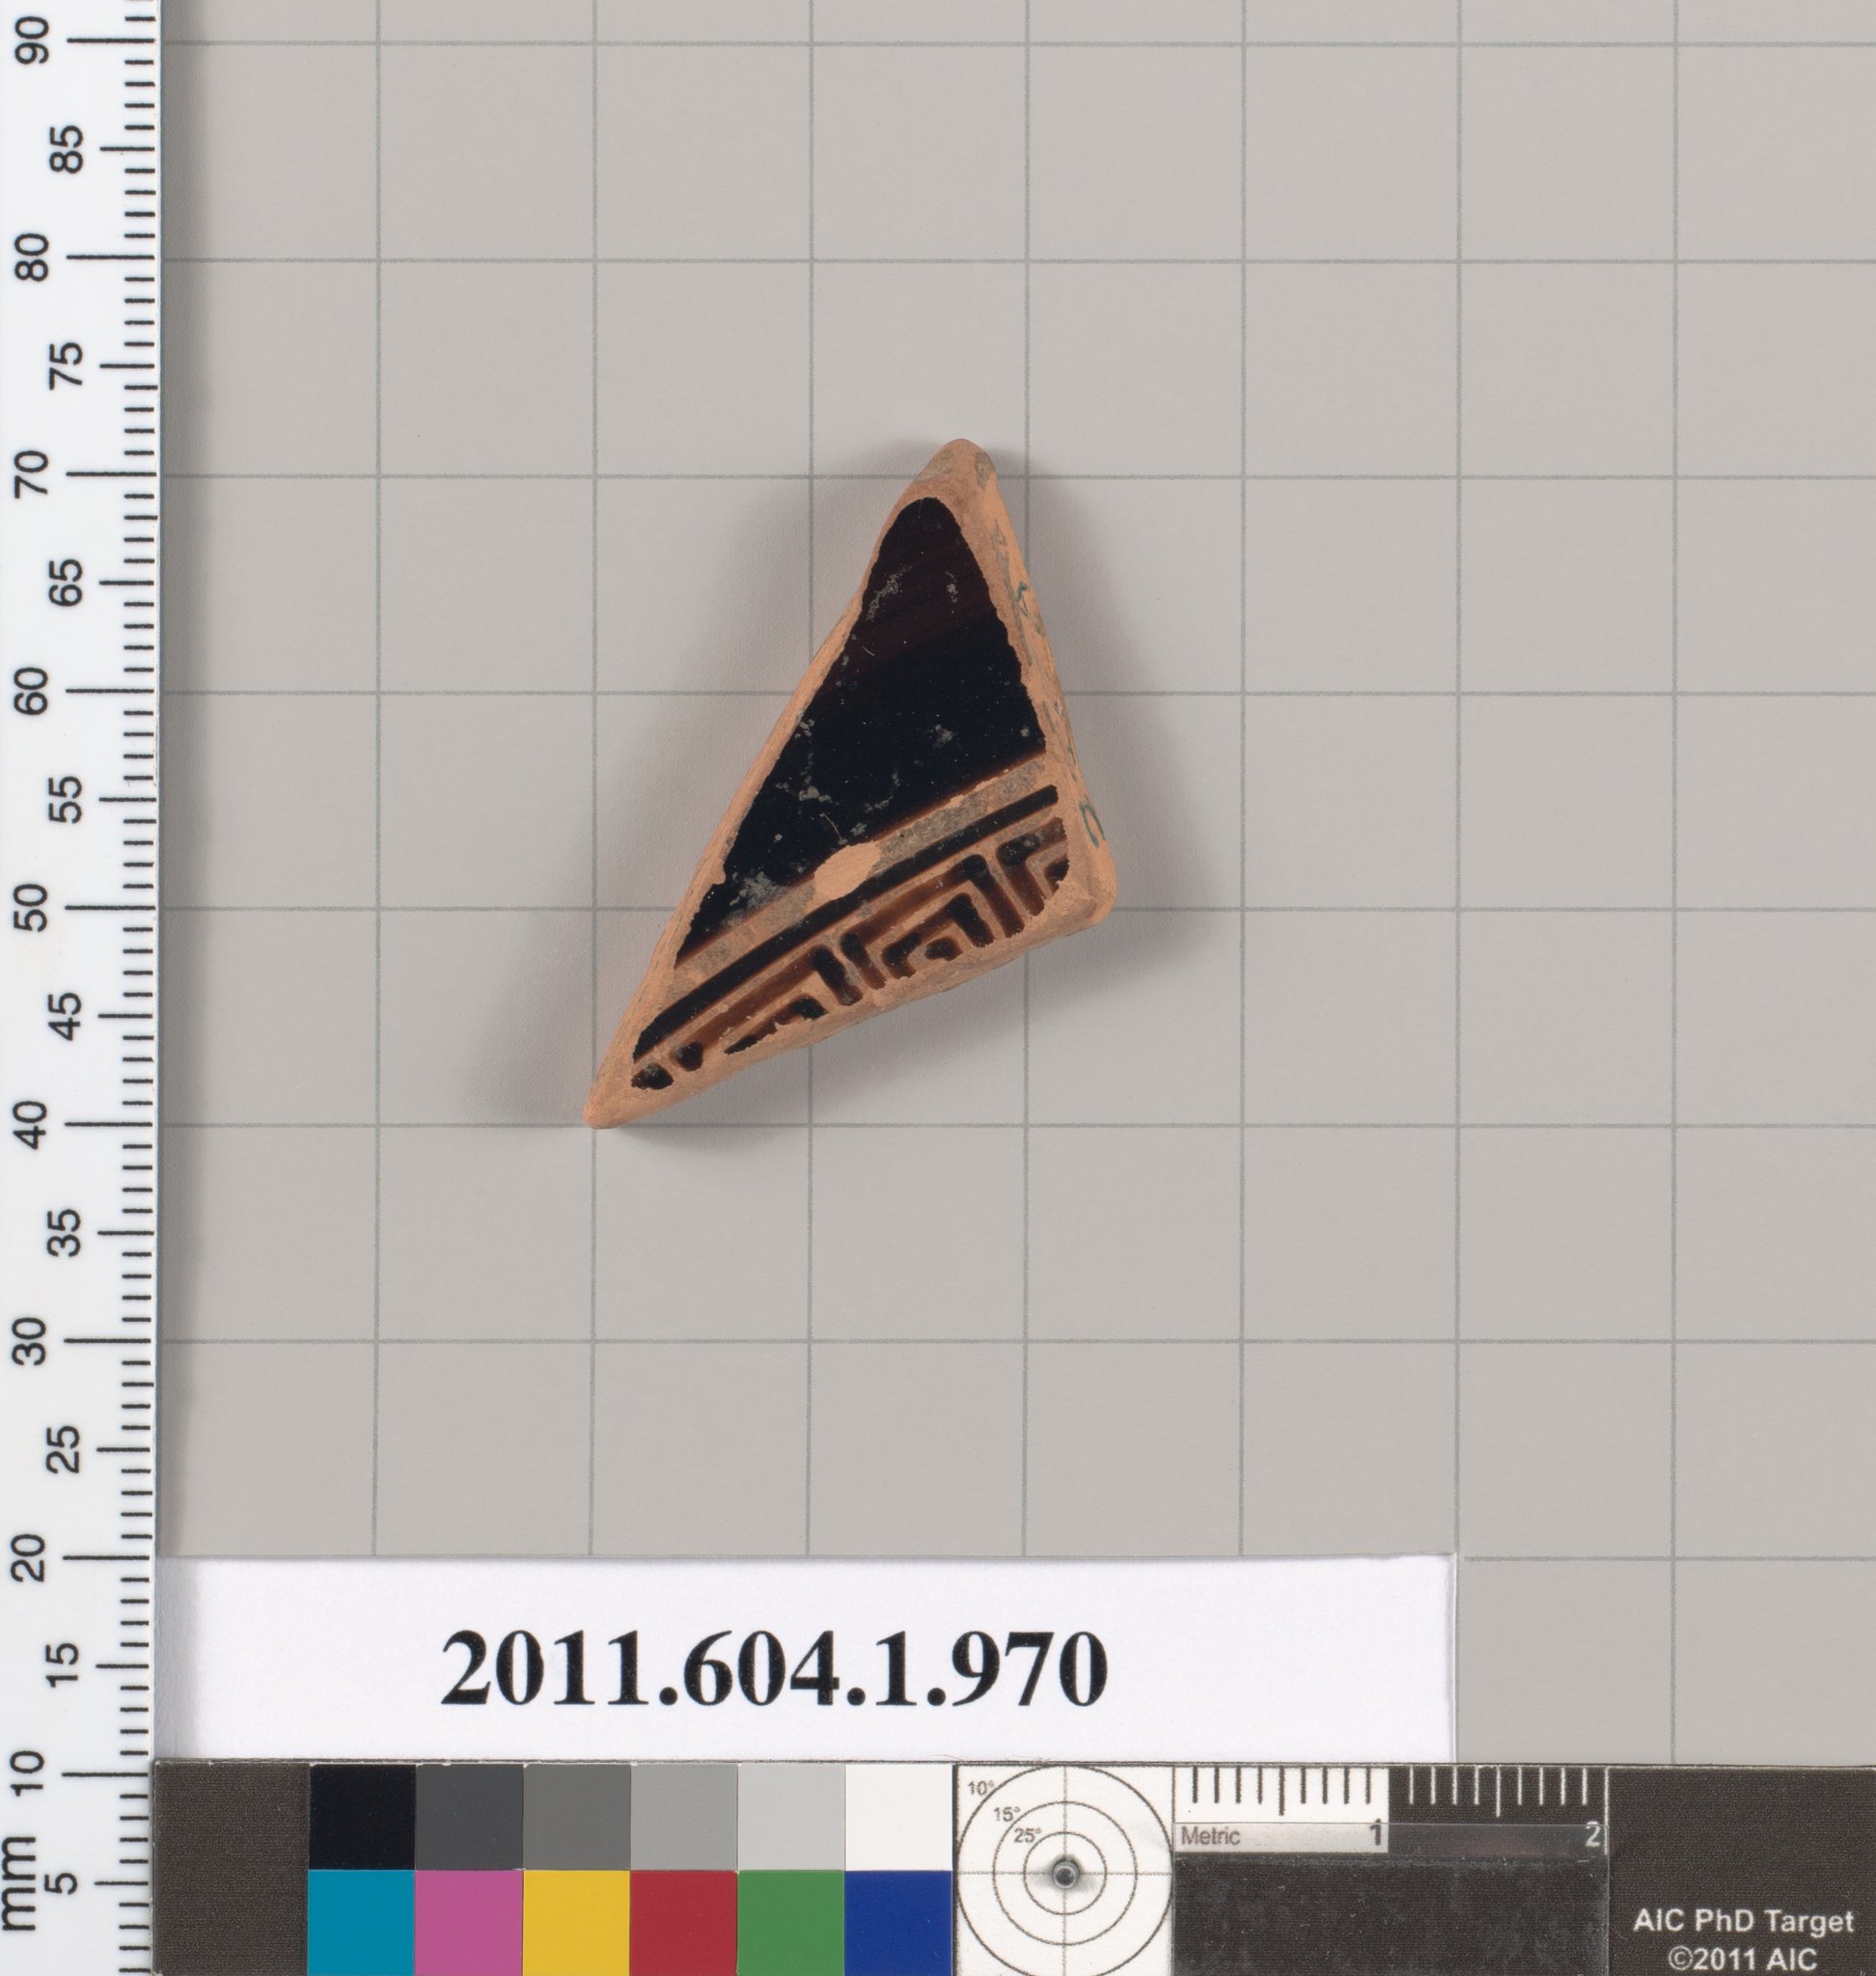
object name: kylix fragment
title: Terracotta fragment of a kylix (drinking cup)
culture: greek, attic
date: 490-480 BCE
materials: terracotta